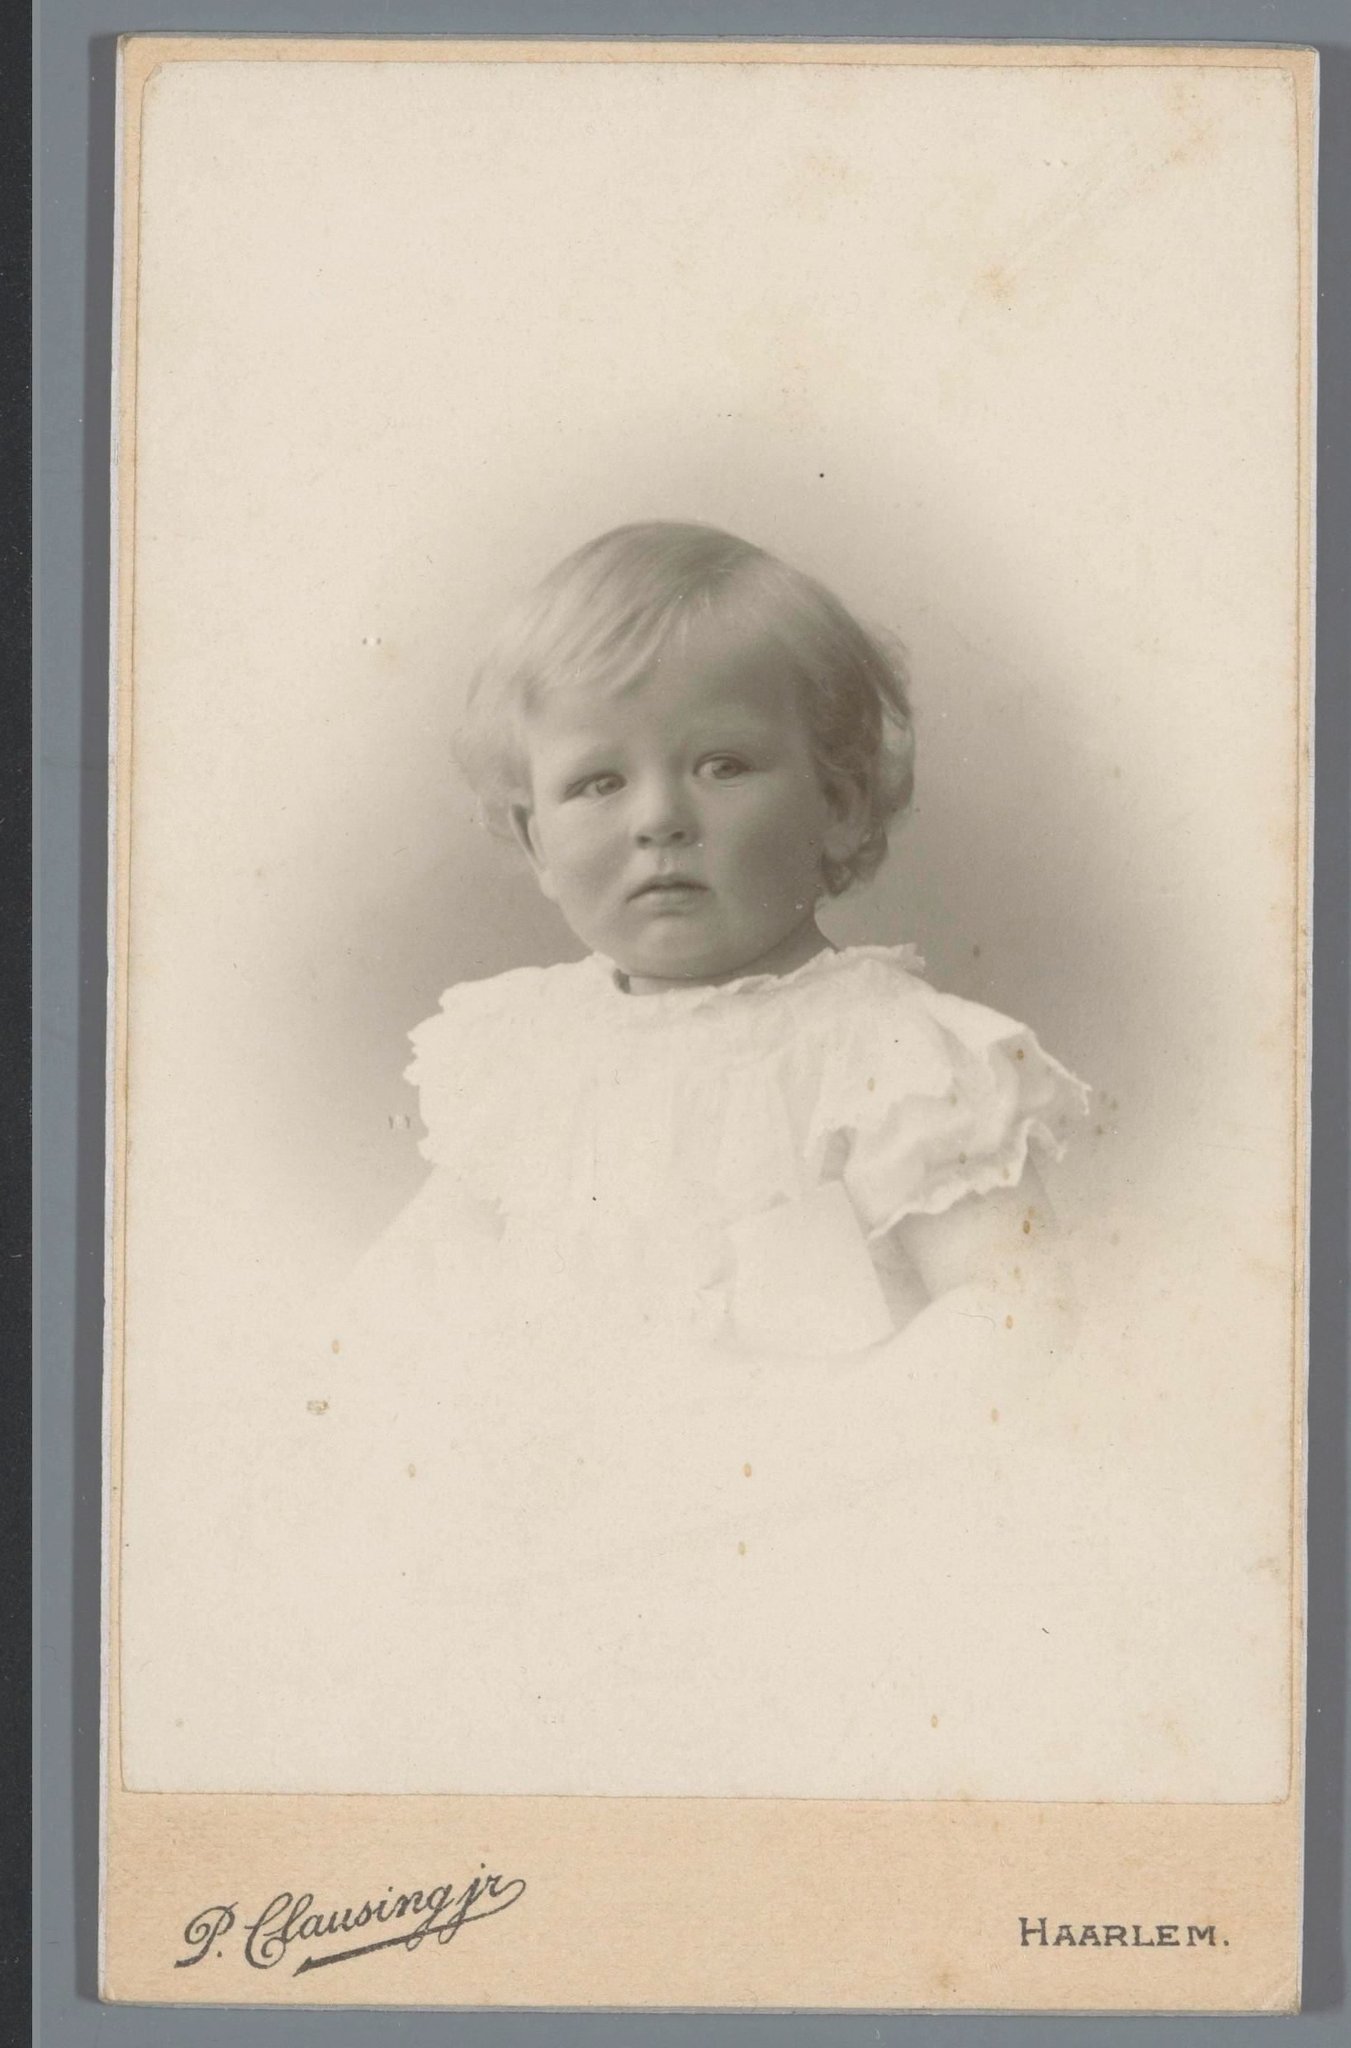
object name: photograph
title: Portret van Gerard Herman Broos, 15 maanden oud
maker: peter clausing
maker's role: fotograaf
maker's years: 1870-1913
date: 1903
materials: paper, cardboard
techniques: gelatin silver print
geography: haarlem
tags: historical persons, infant, baby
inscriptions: address: ‘HAARLEM/ Baan 9 B.’, inscription: ‘Prager & Lojda, Berlin./ 10203’